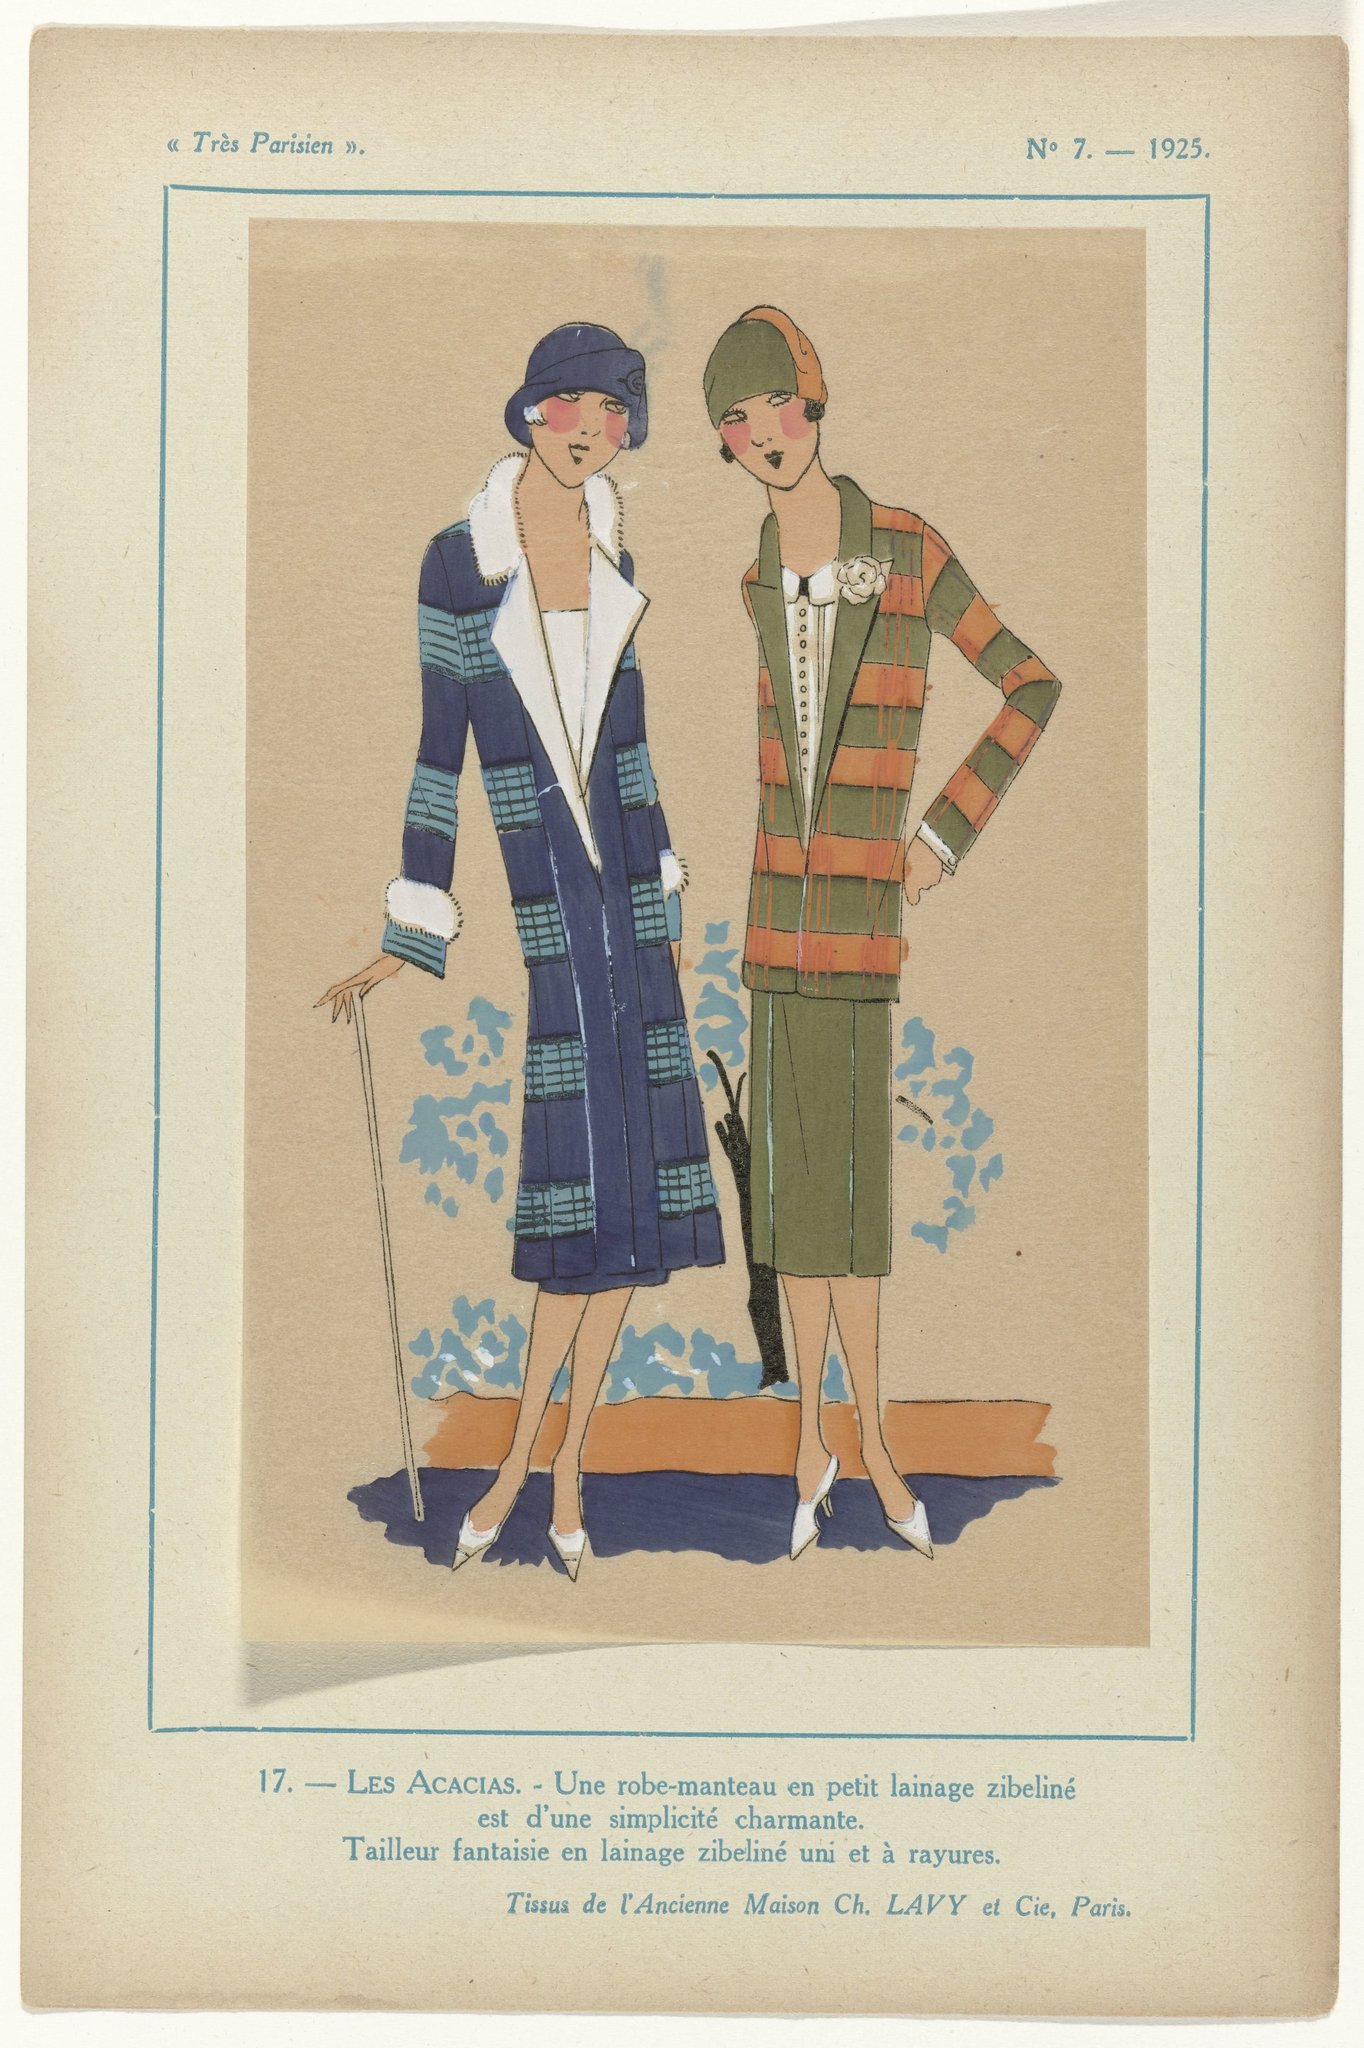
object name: fashion print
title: Très Parisien, 1925, No 7, Pl. 17. - LES ACACIAS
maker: g-p. joumard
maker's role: publisher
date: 1925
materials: paper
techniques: hand coloring, letterpress printing, lithography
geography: paris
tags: walking-stick, staff, cane (+ women's clothes), ensembles of pieces of clothing (tailleur) (+ women's clothes), fashion plates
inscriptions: caption: ‘17. - LES ACACIAS. - Une robe-manteau en petit lainage zibeliné est d'une simplicité charmante. Tailleur fantaisie en lainage zibeliné uni et à rayures.’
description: Een robe-manteau van wol, manchetten en kraag afgezet met bont. Mantelpak van wol met een gestreept jasje. Stoffen van Ch. Lavy, Parijs. Prent uit het modetijdschrift Très Parisien...La Mode, Le Chic, L'Élégance (1920-1936)